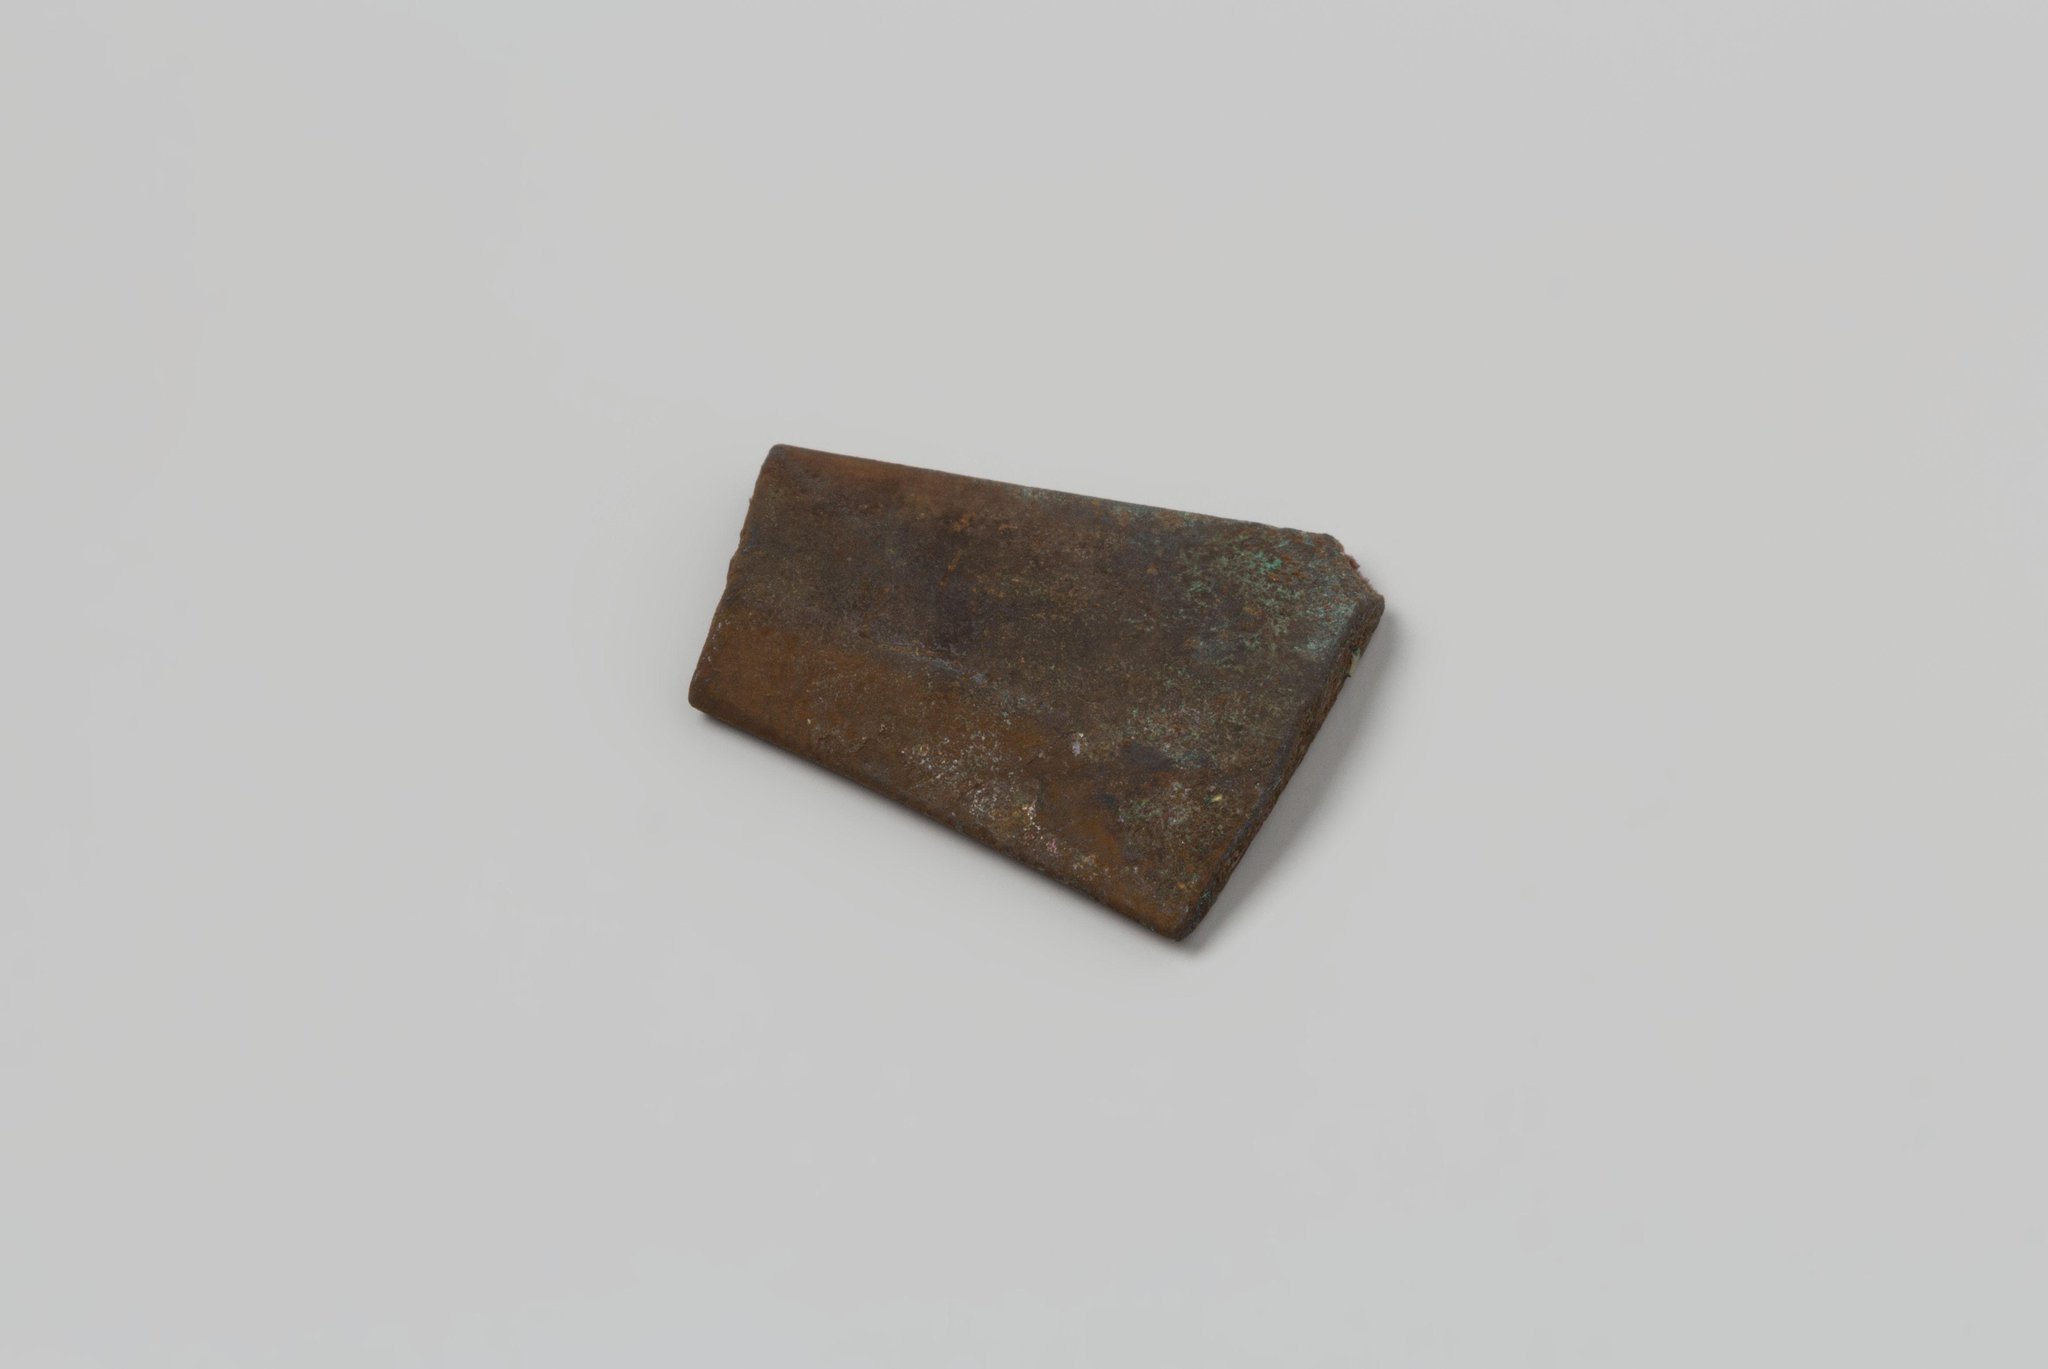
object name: spoon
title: Fragment steel van vork of lepel uit het wrak van de Oost-Indiëvaarder Hollandia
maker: Anonymous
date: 1700-1743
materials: silver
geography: netherlands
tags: verenigde oostindische compagnie, hollandia (schip), annet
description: Cutlery, fragment: stem of fork or spoon; fragm, flat, widening.